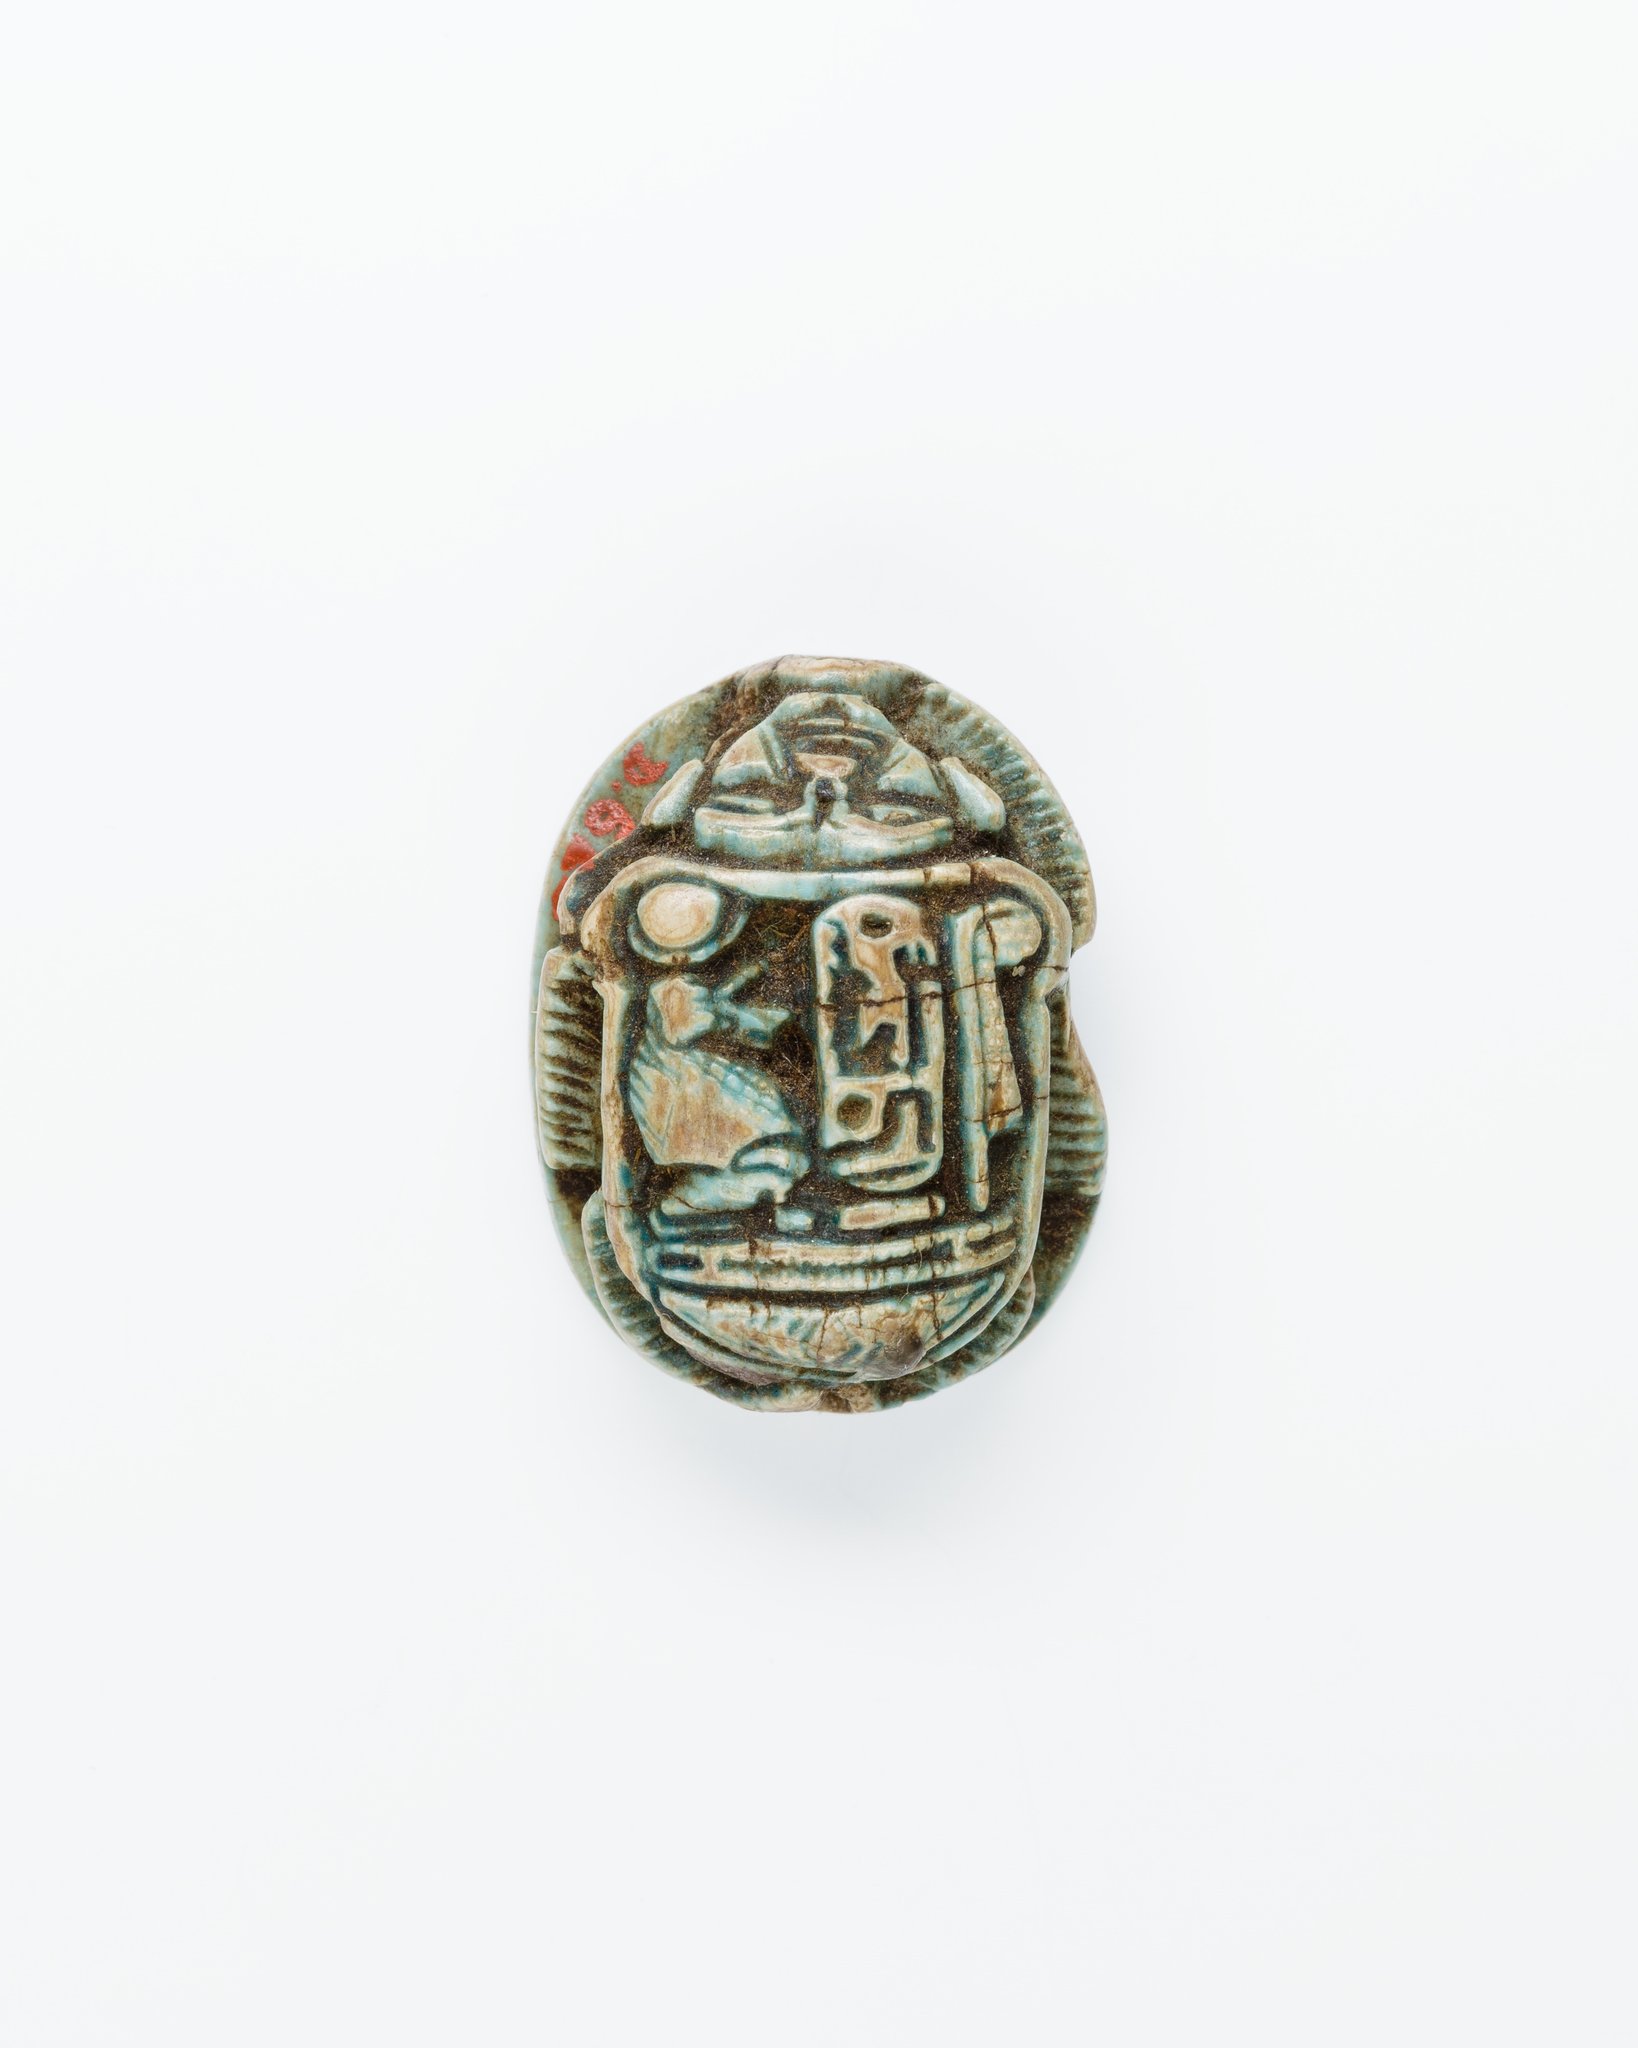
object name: scarab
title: Scarab with ornate back including prenomen of Ramesses II and the phrase beloved of Maat and Thoth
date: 1294-1213 BCE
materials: stone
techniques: glazing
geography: egypt